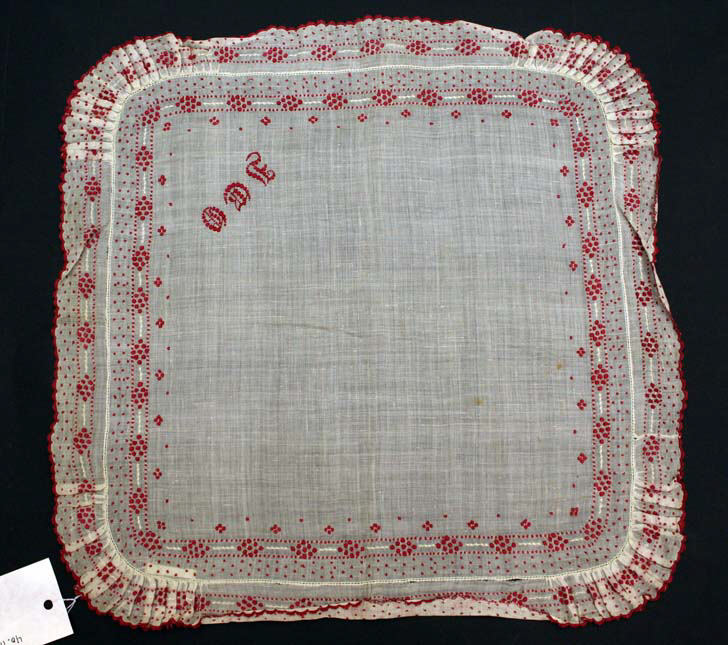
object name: handkerchief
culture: american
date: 1860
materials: cotton